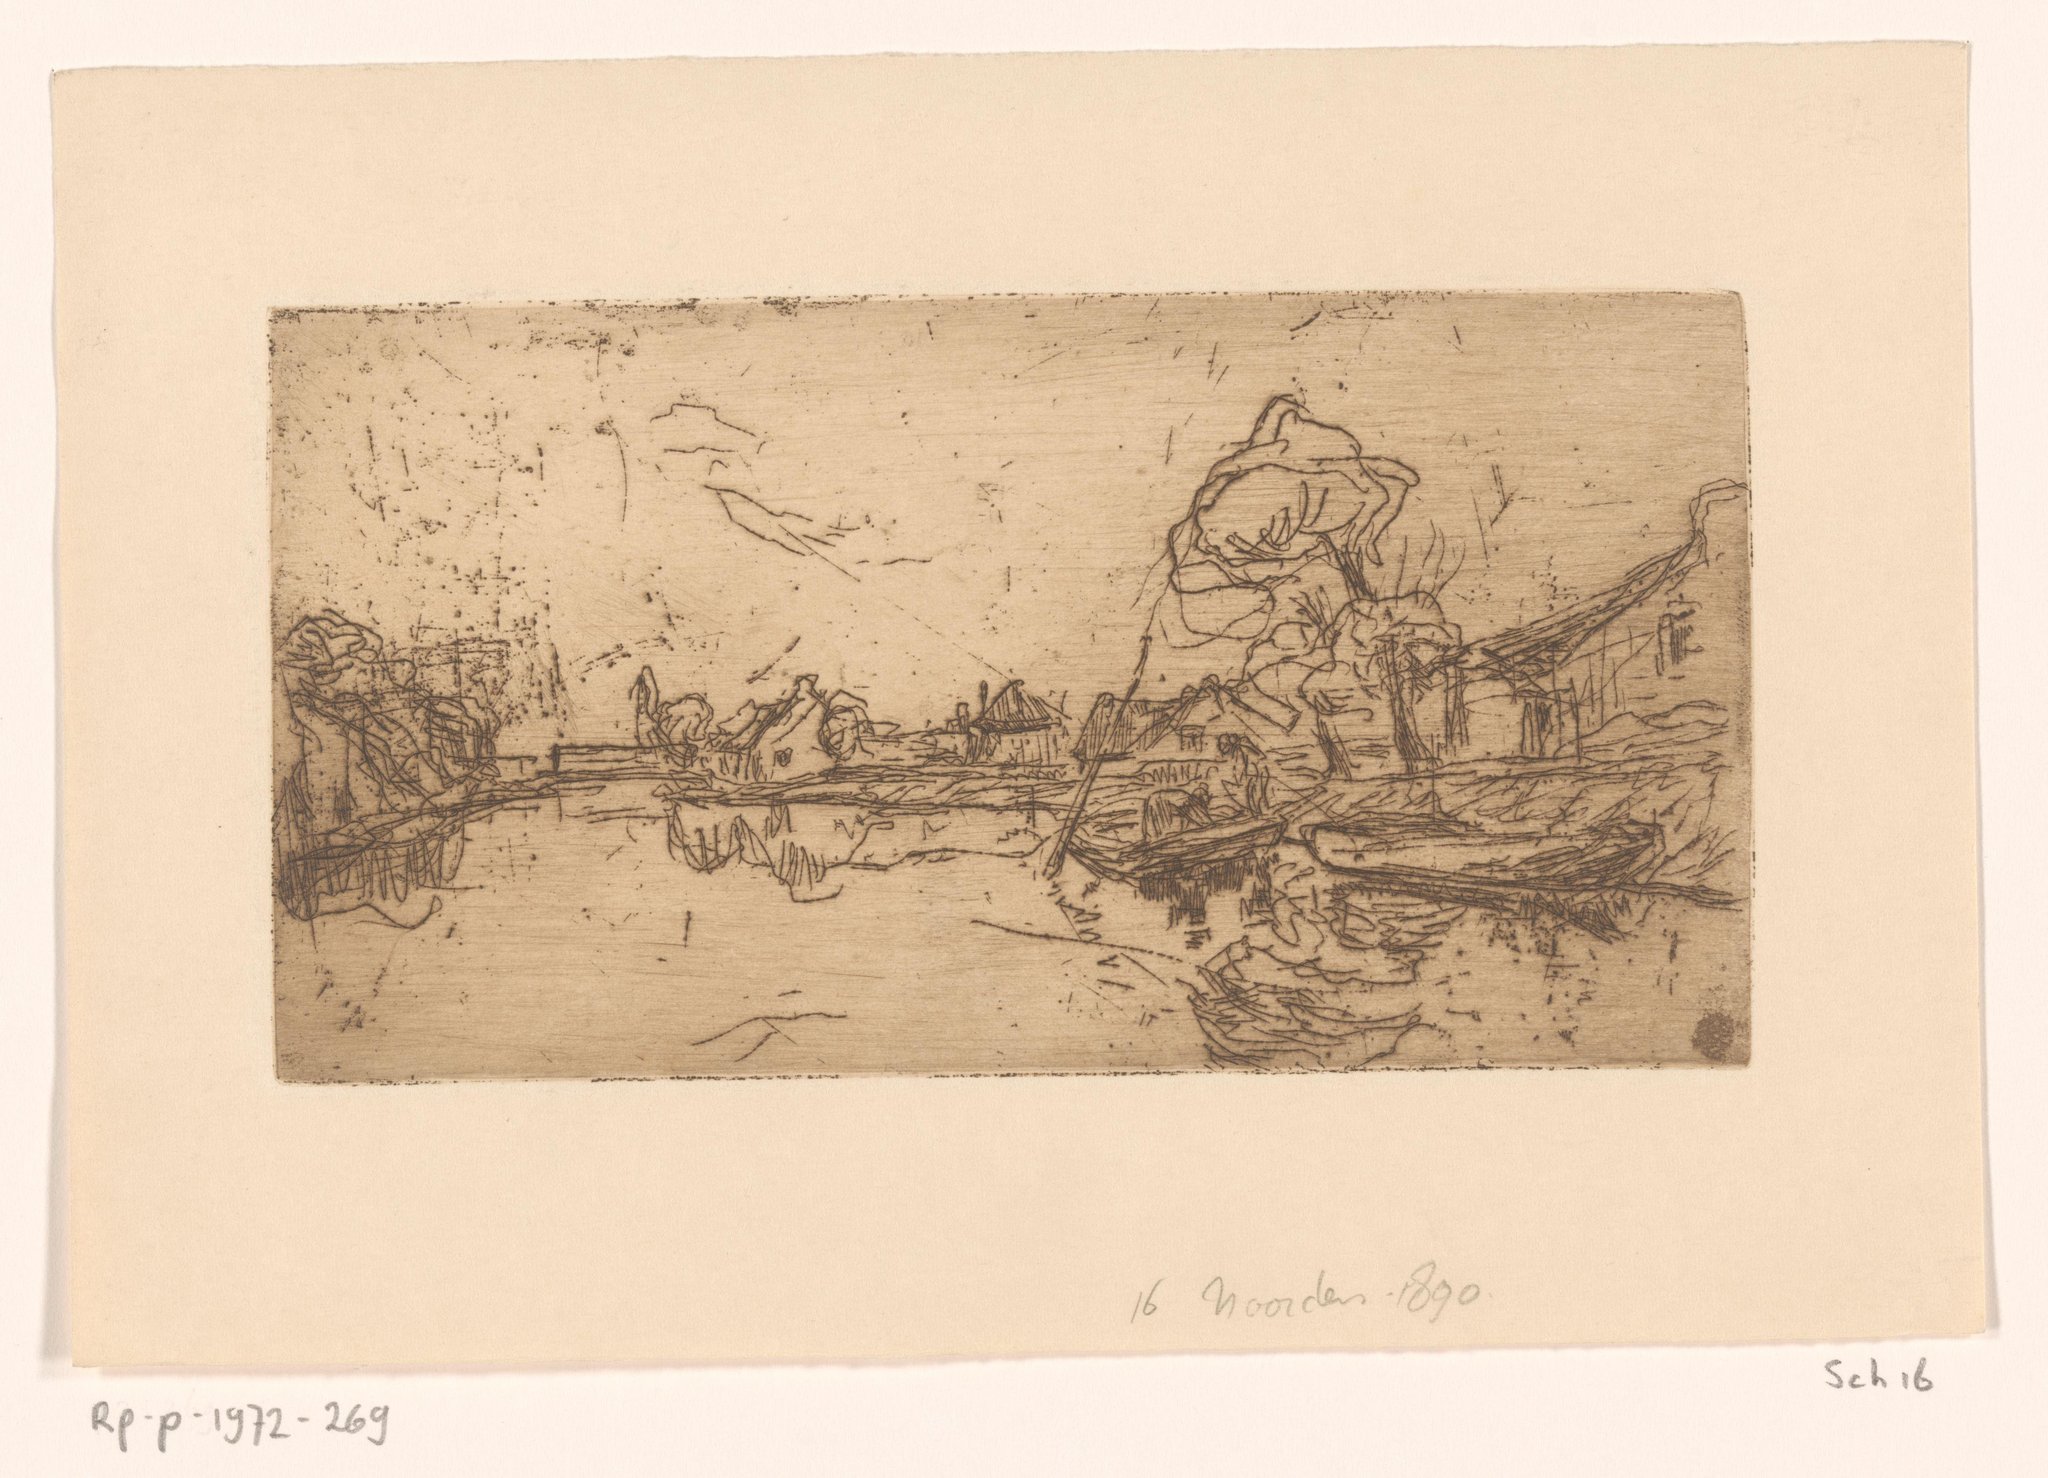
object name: print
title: Noorden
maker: floris verster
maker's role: draughtsman, painter, print maker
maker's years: 1861-1927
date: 1890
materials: paper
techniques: drypoint, etching, intaglio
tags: river, rowing-boat, canoe, etc.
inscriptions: collector's mark: Lugt 2760, collector's mark: Lugt 2228